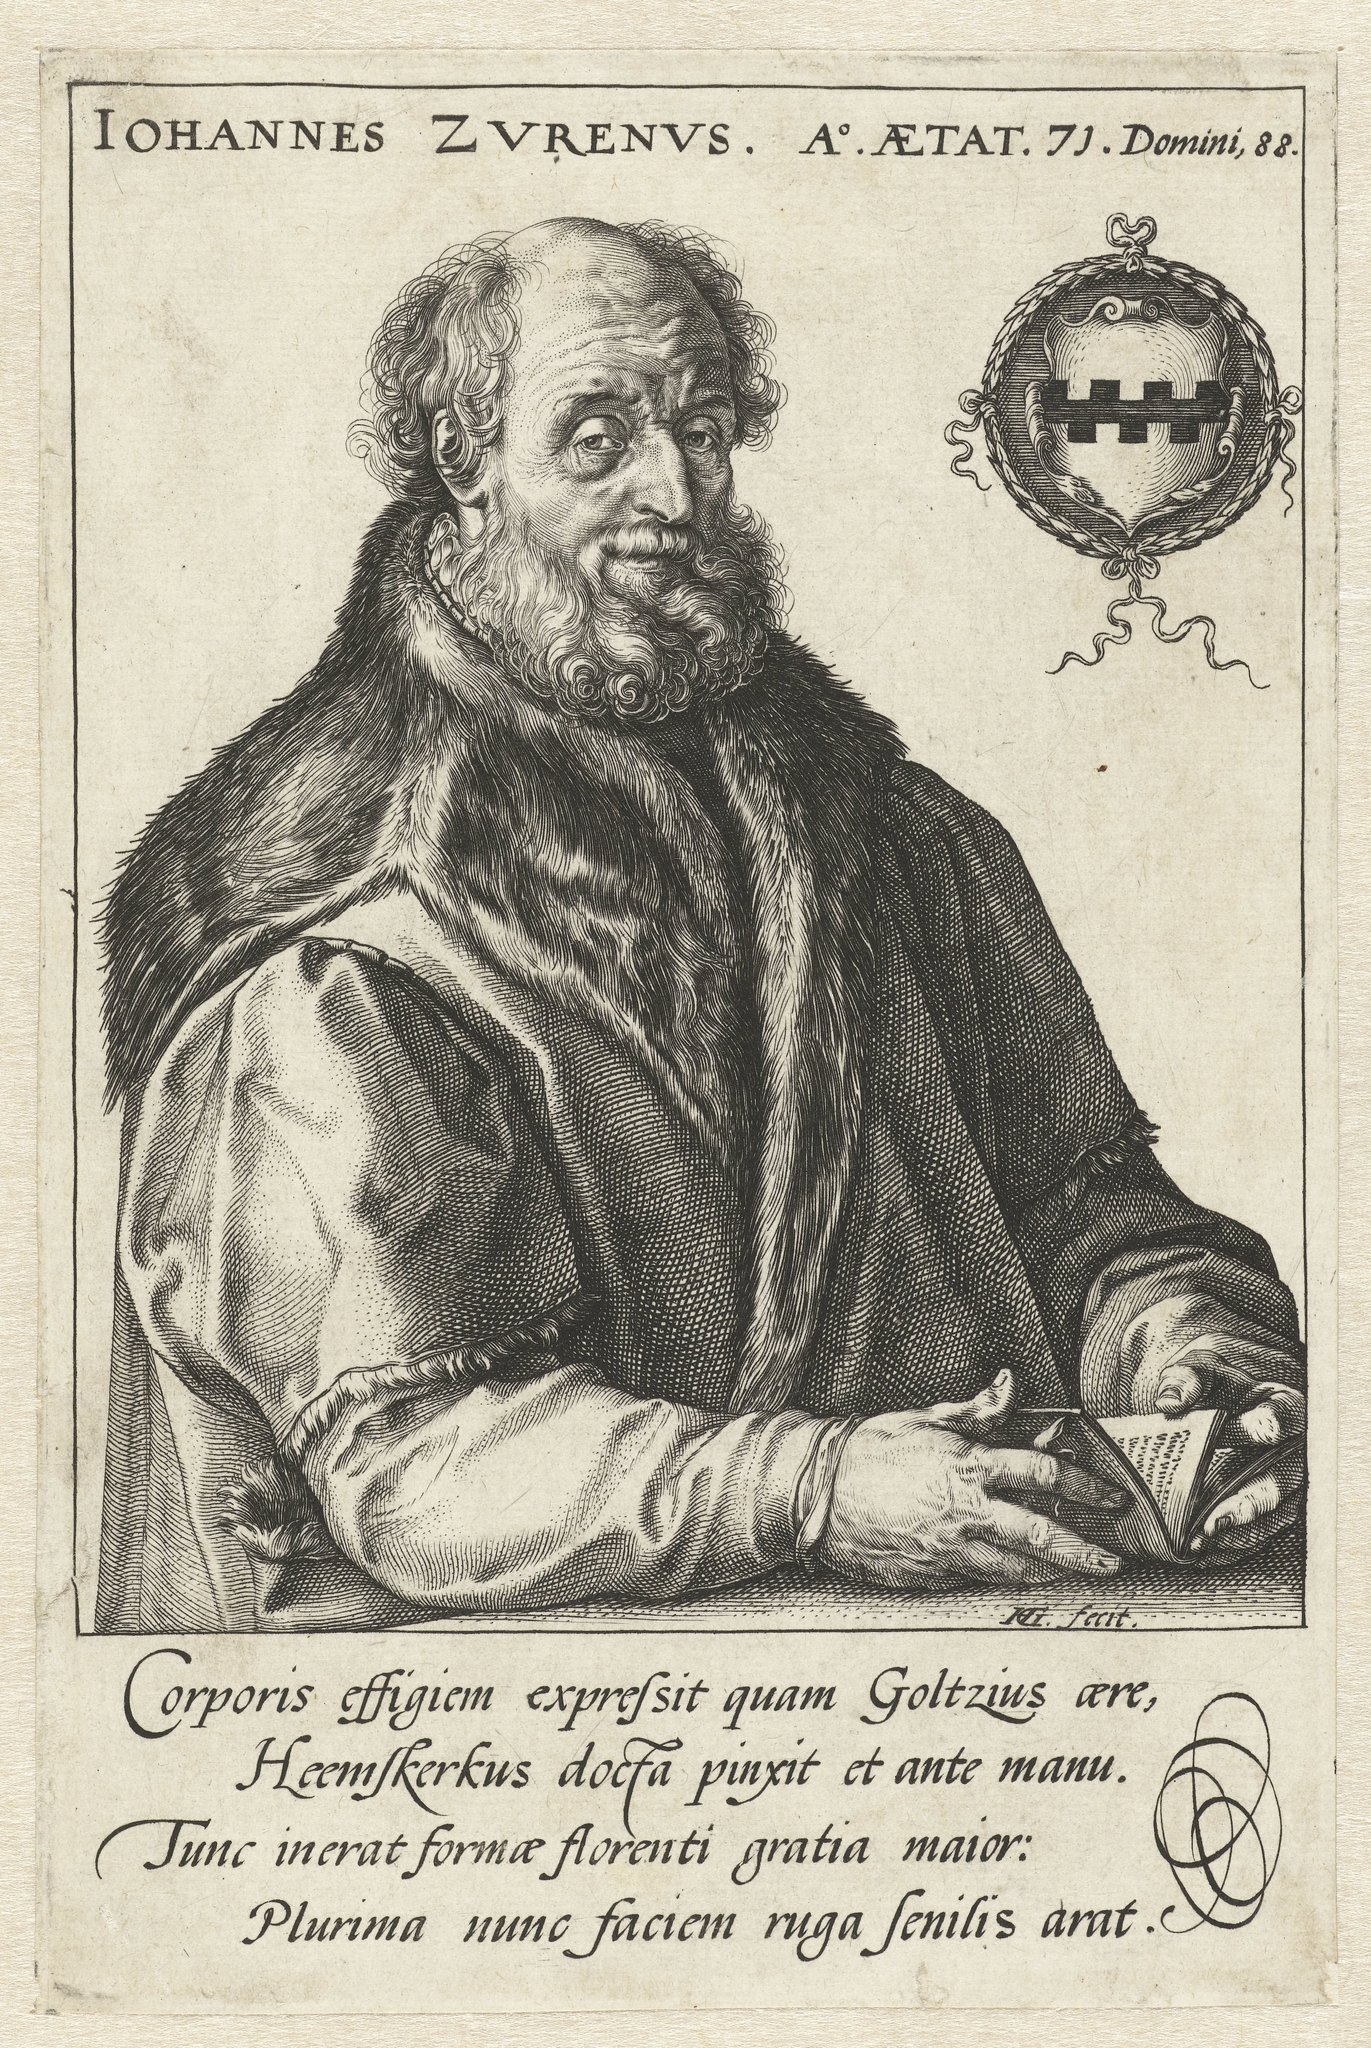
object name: print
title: Iohannes Zvrenvs.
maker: hendrick goltzius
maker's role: draughtsman, painter, print maker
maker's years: 1558-1617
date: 1588-1590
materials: paper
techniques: engraving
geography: haarlem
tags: historical persons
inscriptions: caption: ‘Corporis effigiem...senilis arat.’, signature: ‘HG fecit’, collector's mark: Lugt 240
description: Portret van de drukker/uitgever en burgemeester van Haarlem Jan van Suren (1517-1591). Van Suren is hier 71 jaar oud. Ten halven lijve afgebeeld achter een tafel, min of meer op de rechterzijde gezien, de blik naar de beschouwer. In zijn handen een boekje. Hij is gekleed in een mantel afgezet met bont. Rechtsboven zijn wapen. Vier regels onderschrift in Latijn.